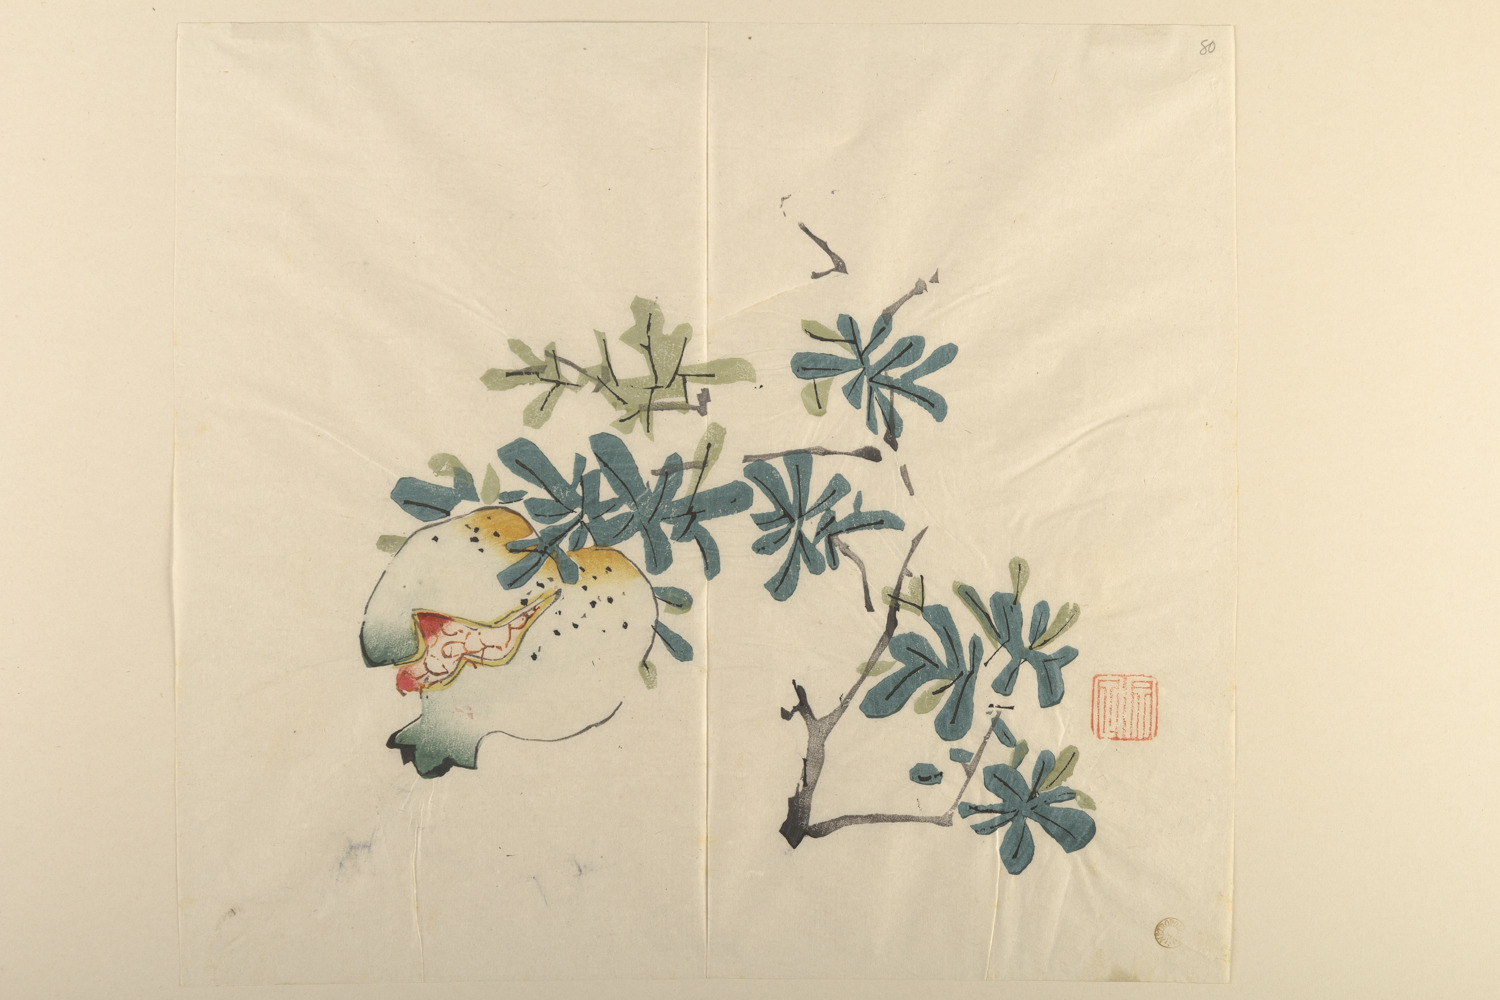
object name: print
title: Page from Shi Zhu Zhai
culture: chinese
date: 1736-1795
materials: ink, paper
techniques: polychrome, woodblock print